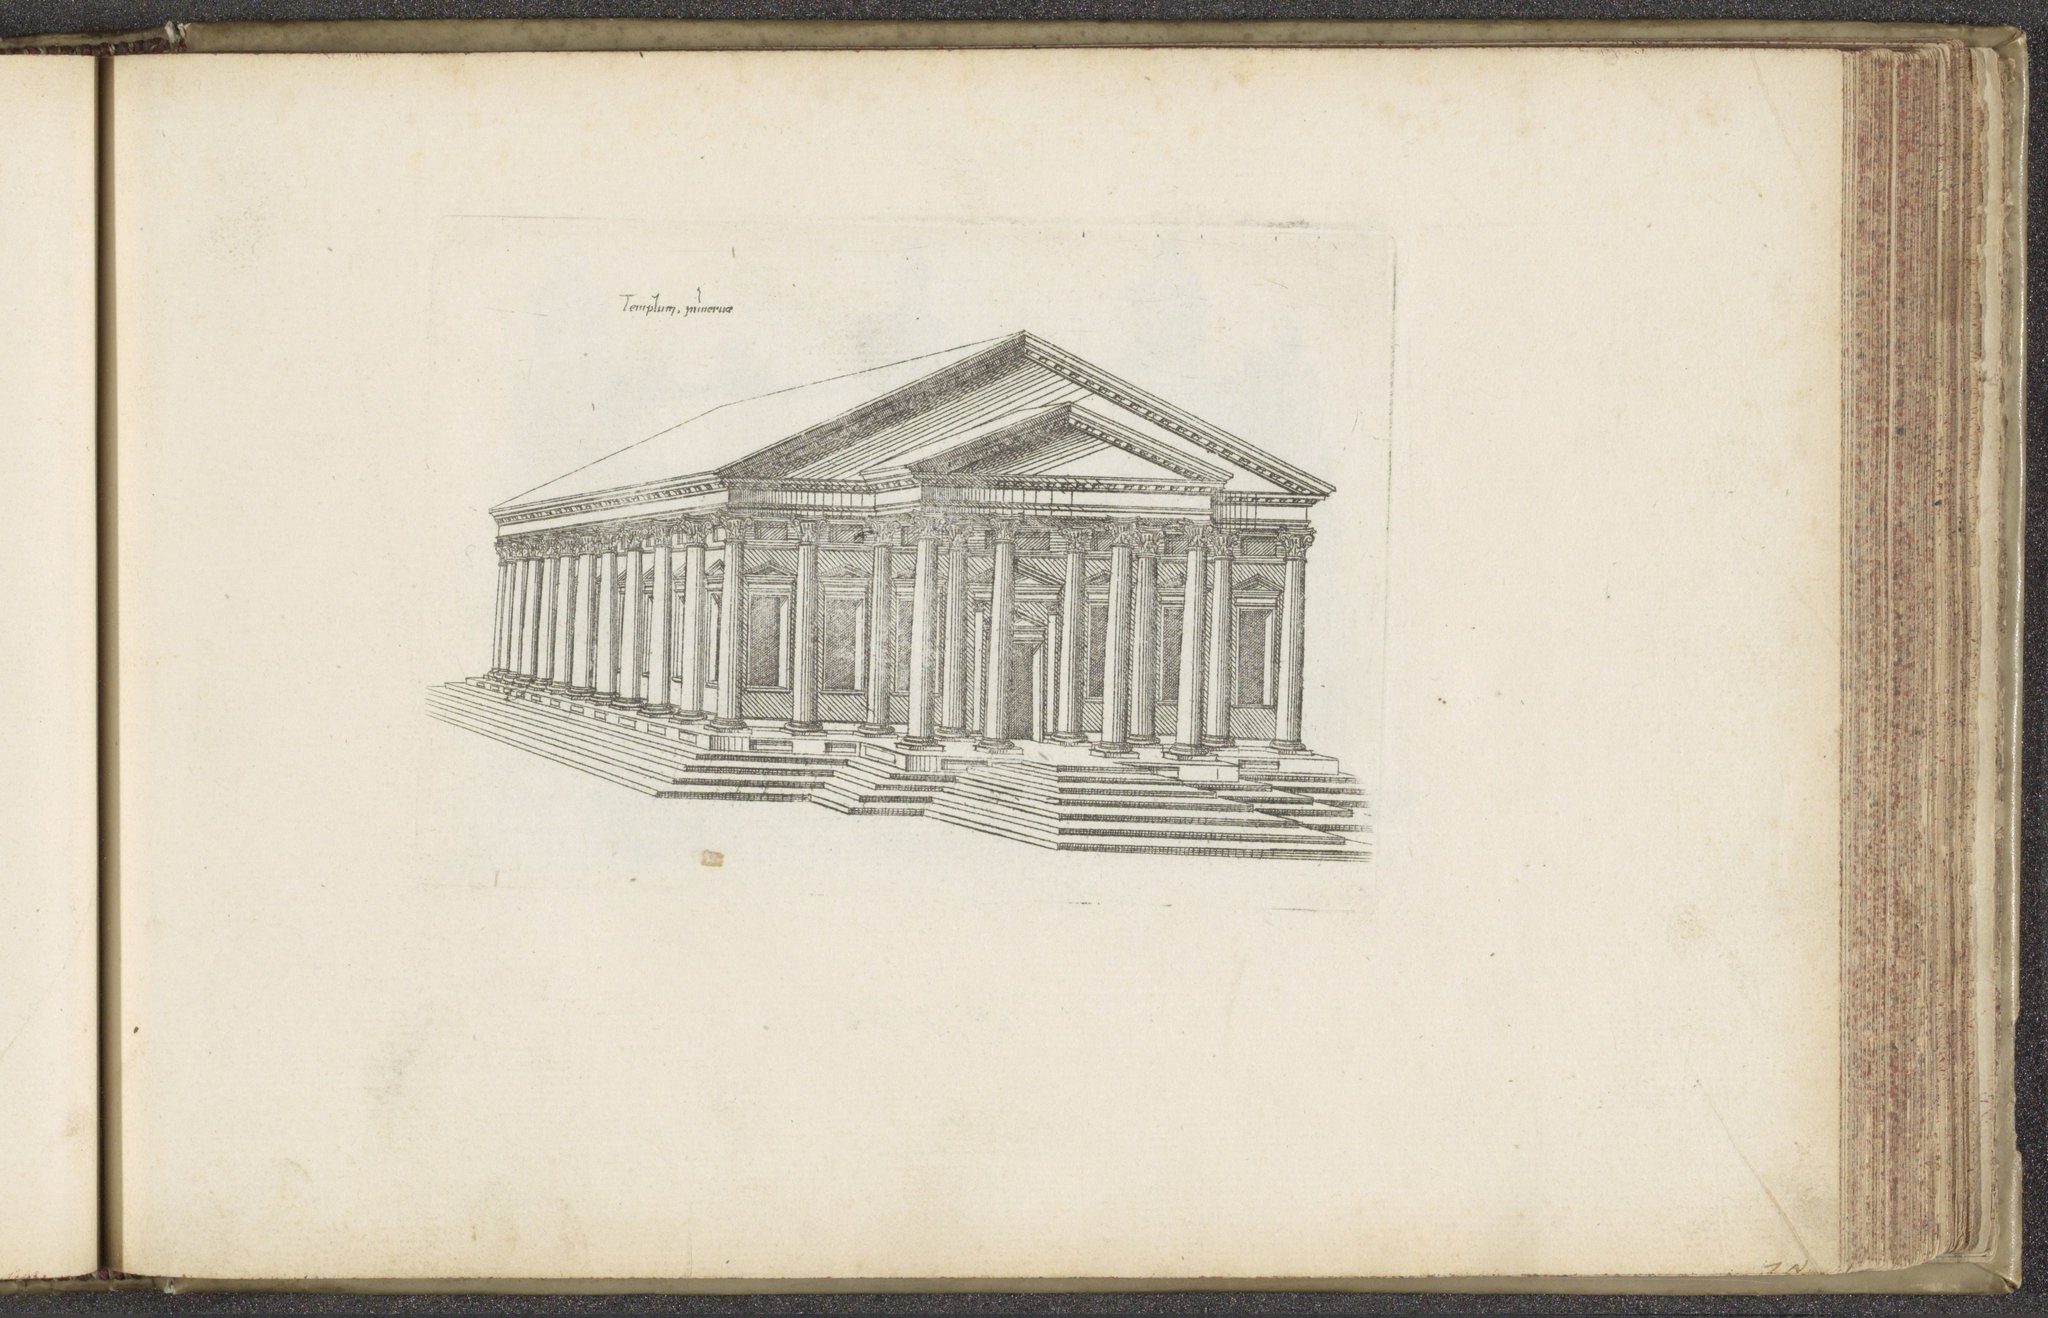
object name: album leaf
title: Tempel van Minerva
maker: jacques androuet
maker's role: draughtsman, print maker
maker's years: 1515-1584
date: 1550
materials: paper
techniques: etching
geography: orléans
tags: temple, shrine ~ roman religion, exterior ~ representation of a building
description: Tempel van Minerva. Deze prent maakt deel uit van een album.